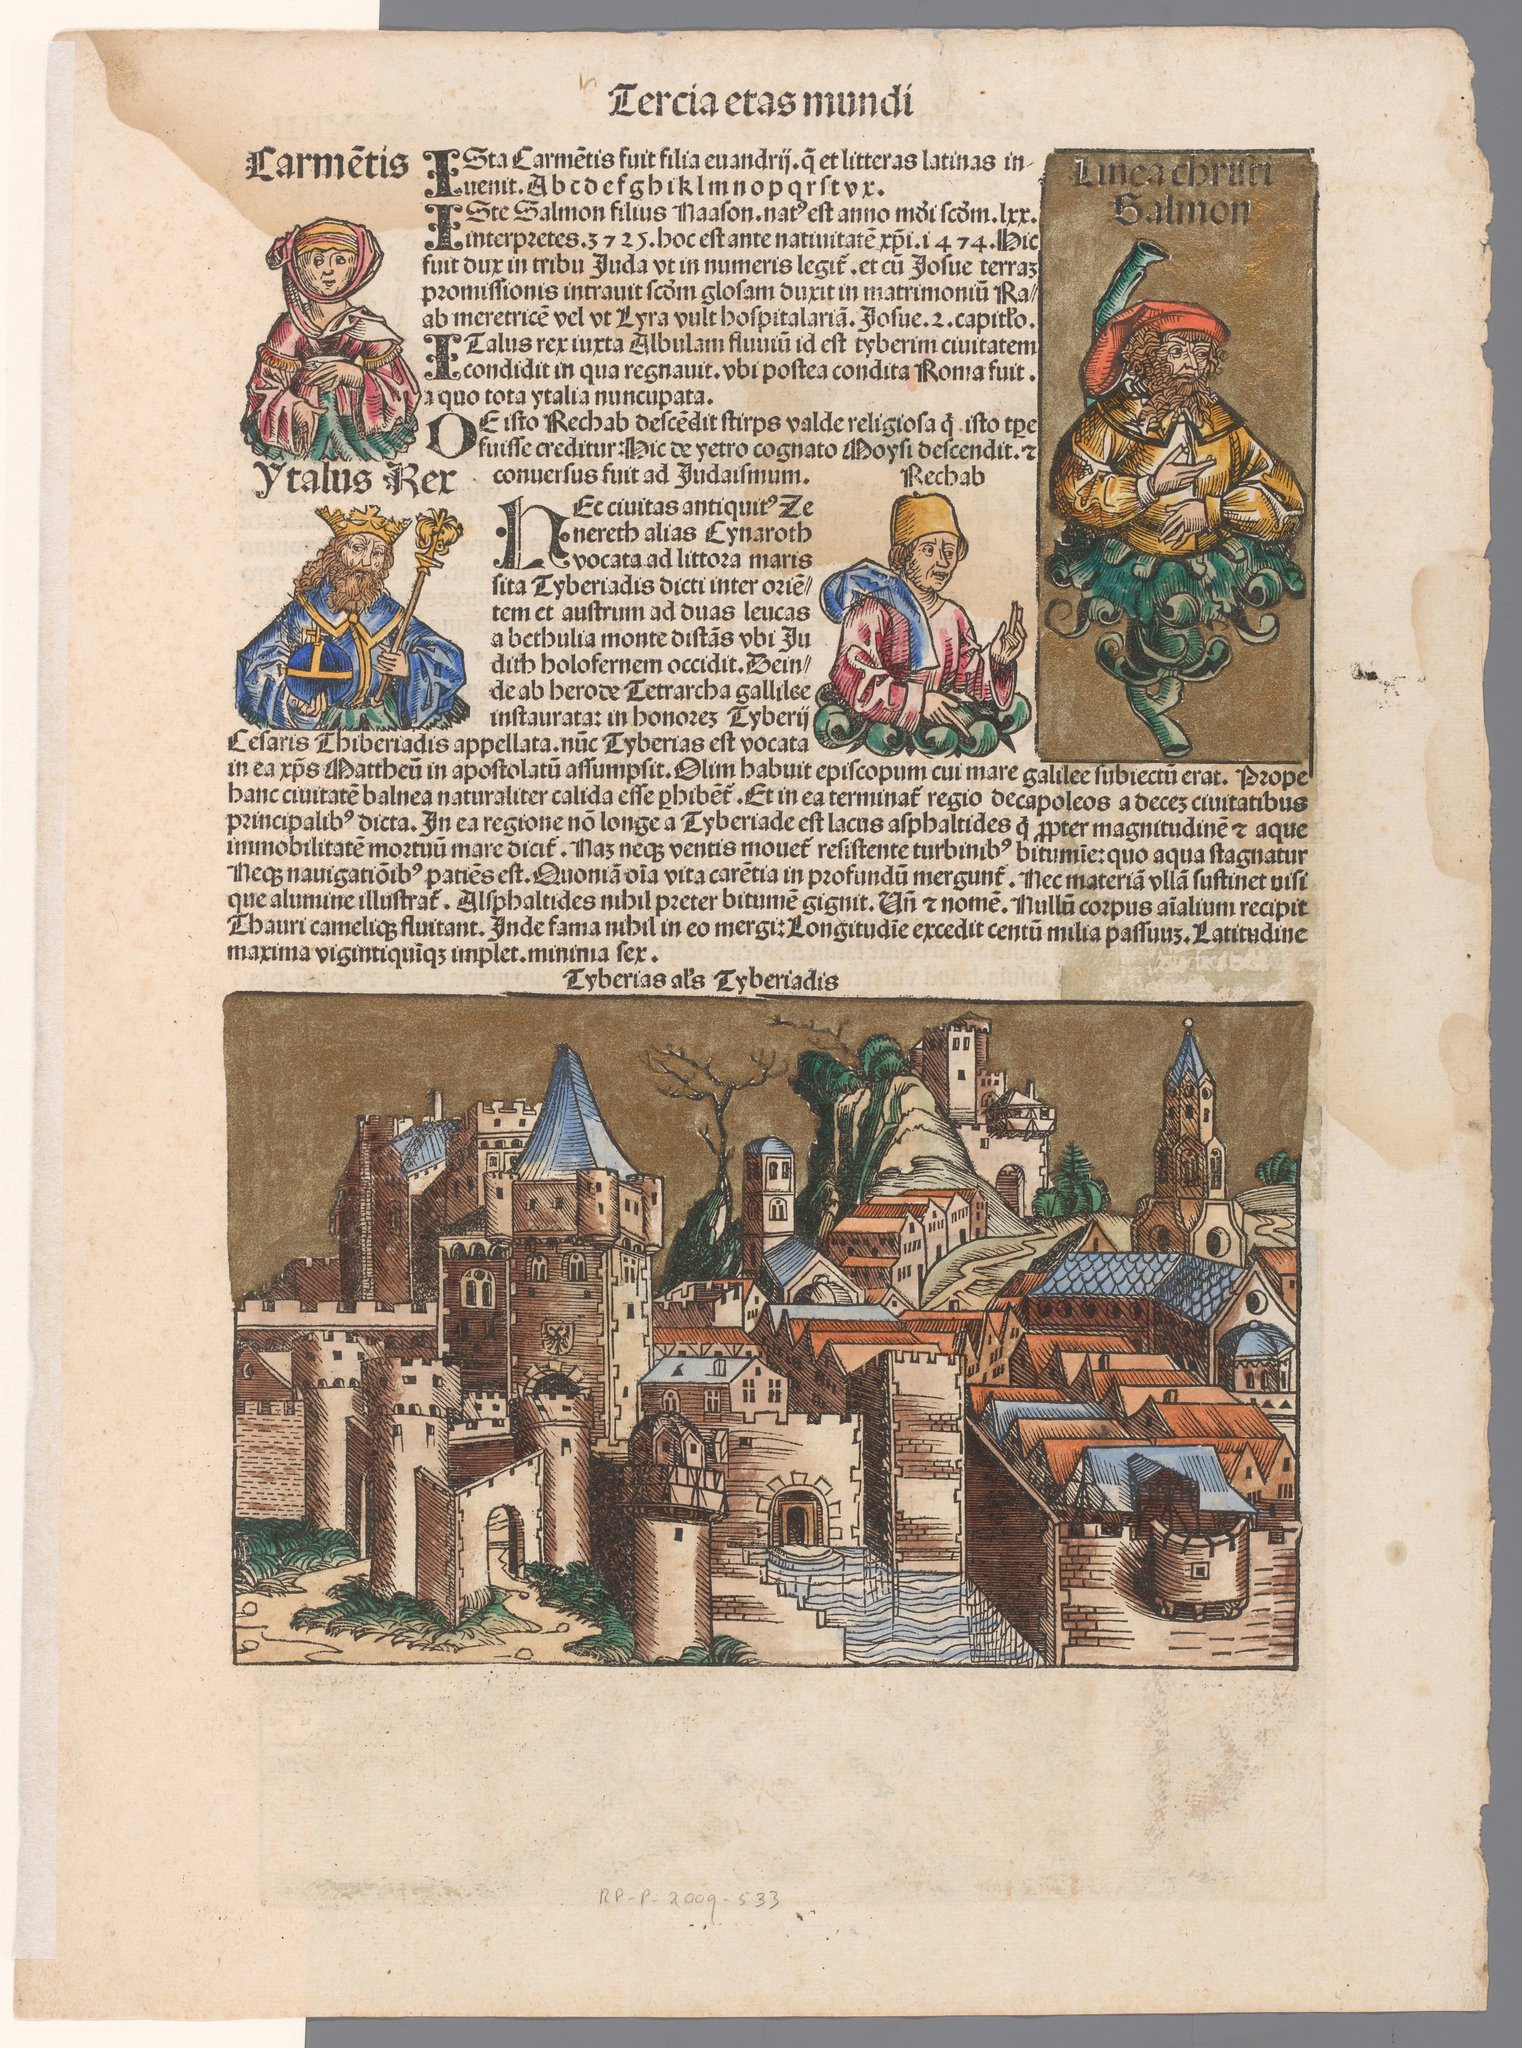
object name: print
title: Bladzijde uit de Neurenbergkroniek van Schedel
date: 1493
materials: paint, paper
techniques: hand coloring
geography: nuremberg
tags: prospect of city, town panorama, silhouette of city - ii - ideal city, (story of) cadmus, city-walls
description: Links en rechts figuren. Links van boven naar beneden: Carmetis, Ytalus Rex. Rechts van links naar rechts: Rechab, Lineachrum Salmon. Onderaan een voorstelling van Tyberias. Een ommuurde stad met in het midden een rivier. Links een kasteeltoren en rechts een kerktoren.